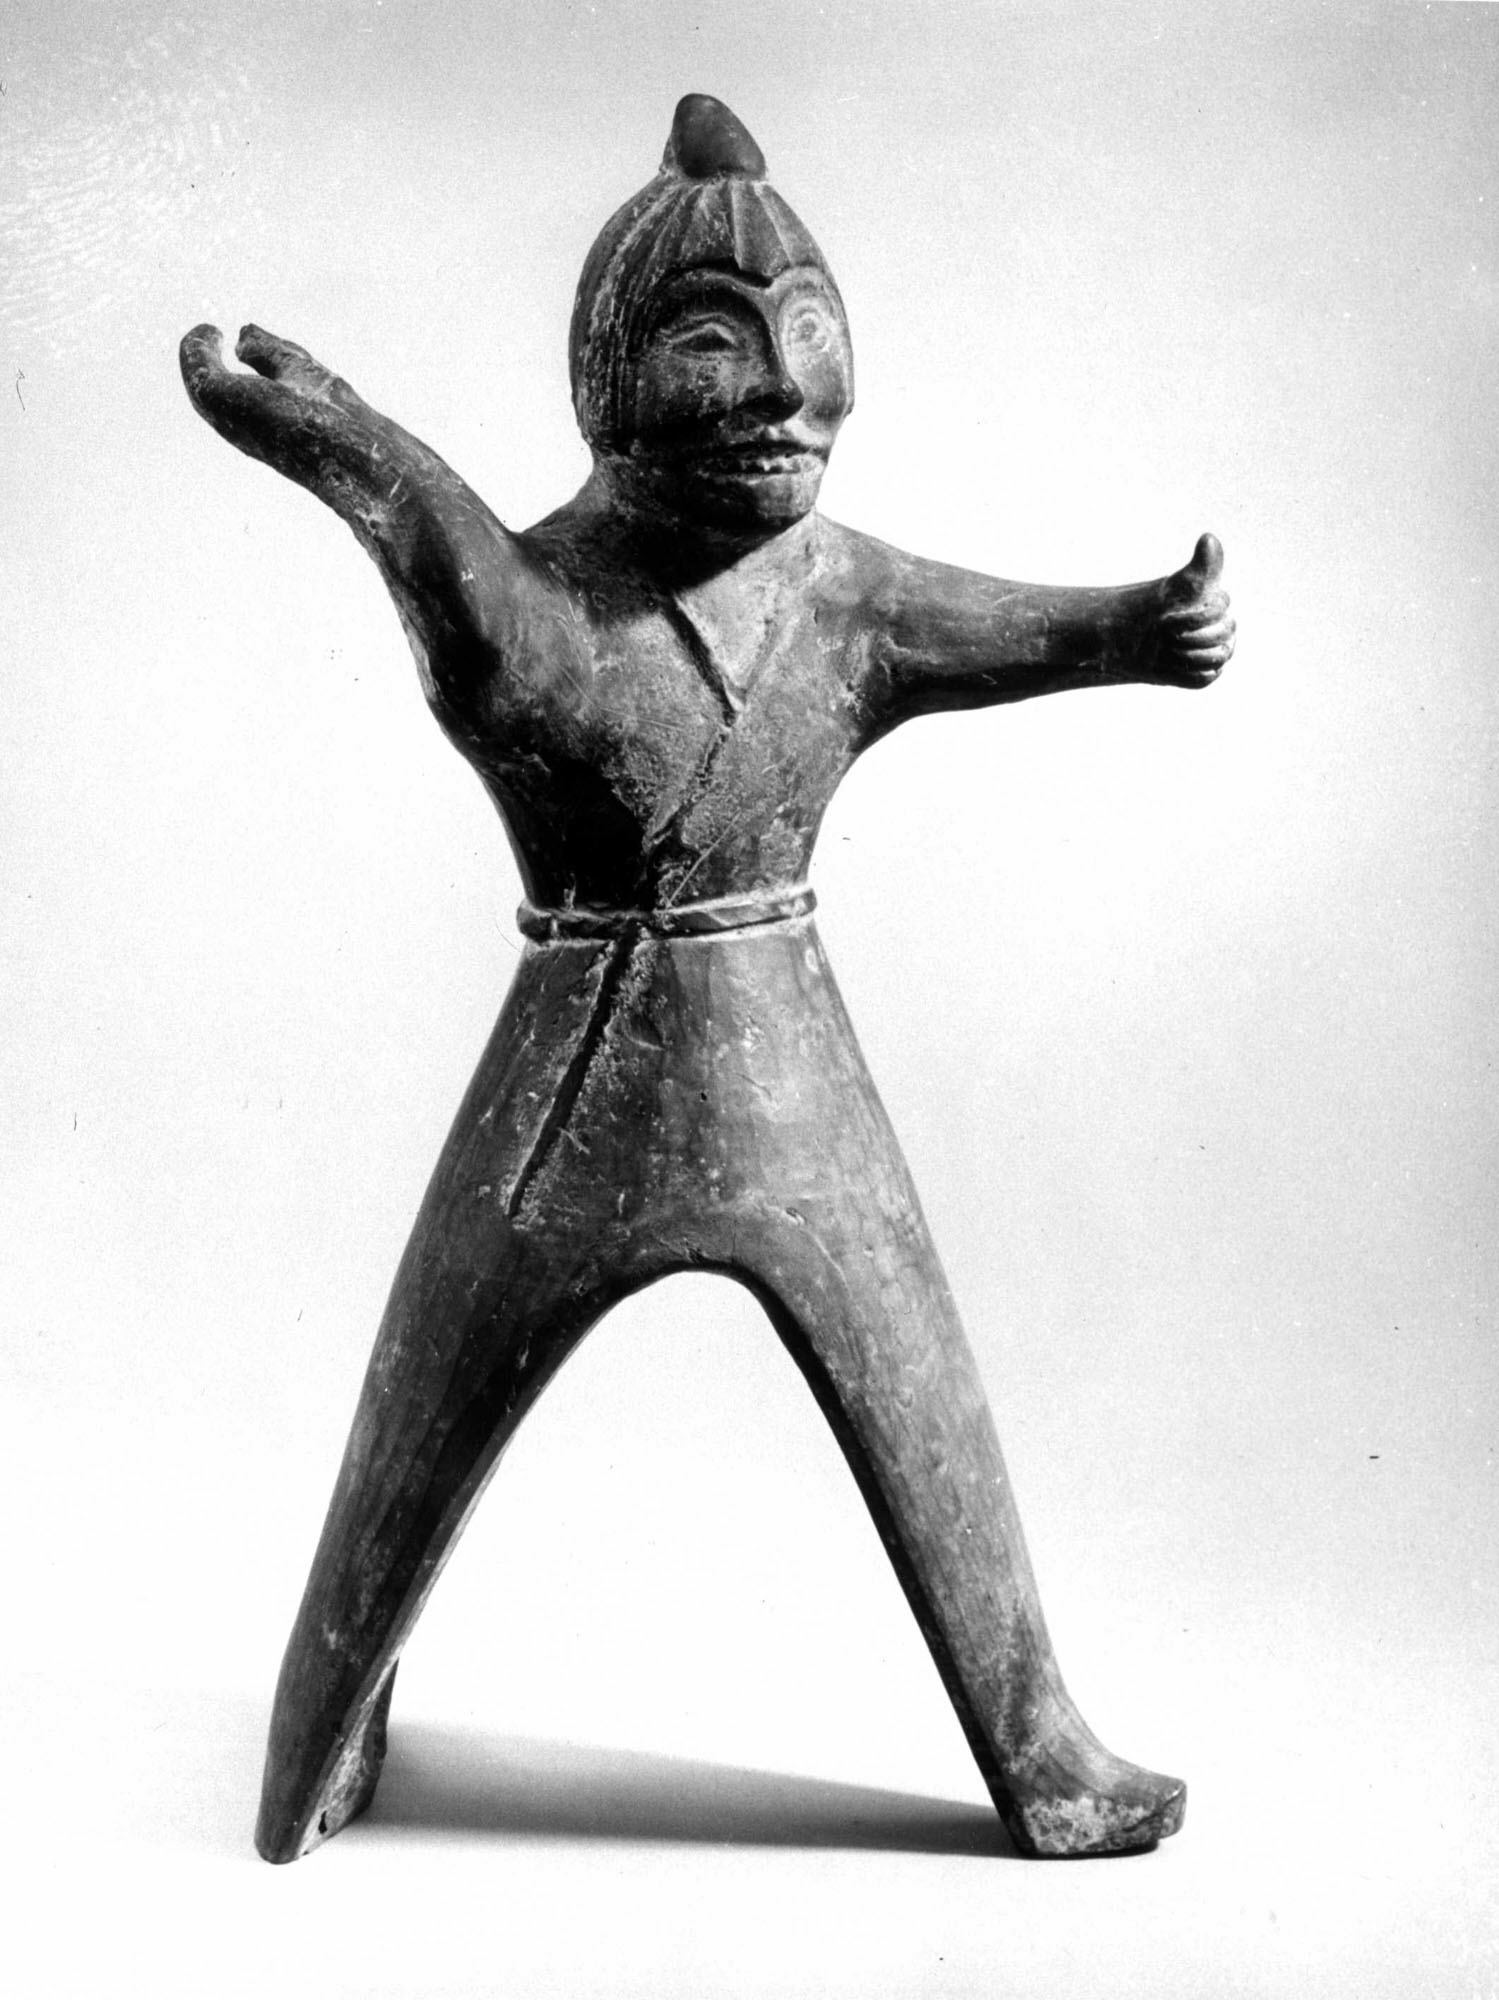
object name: figure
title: Figure of a warrior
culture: chinese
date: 201-400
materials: earthenware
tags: men